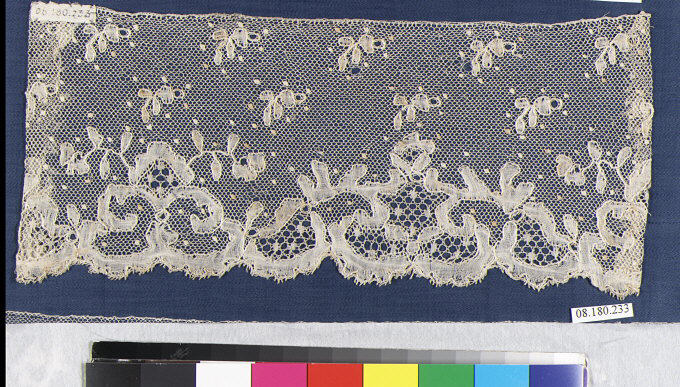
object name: piece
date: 1801-1900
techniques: lace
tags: leaves